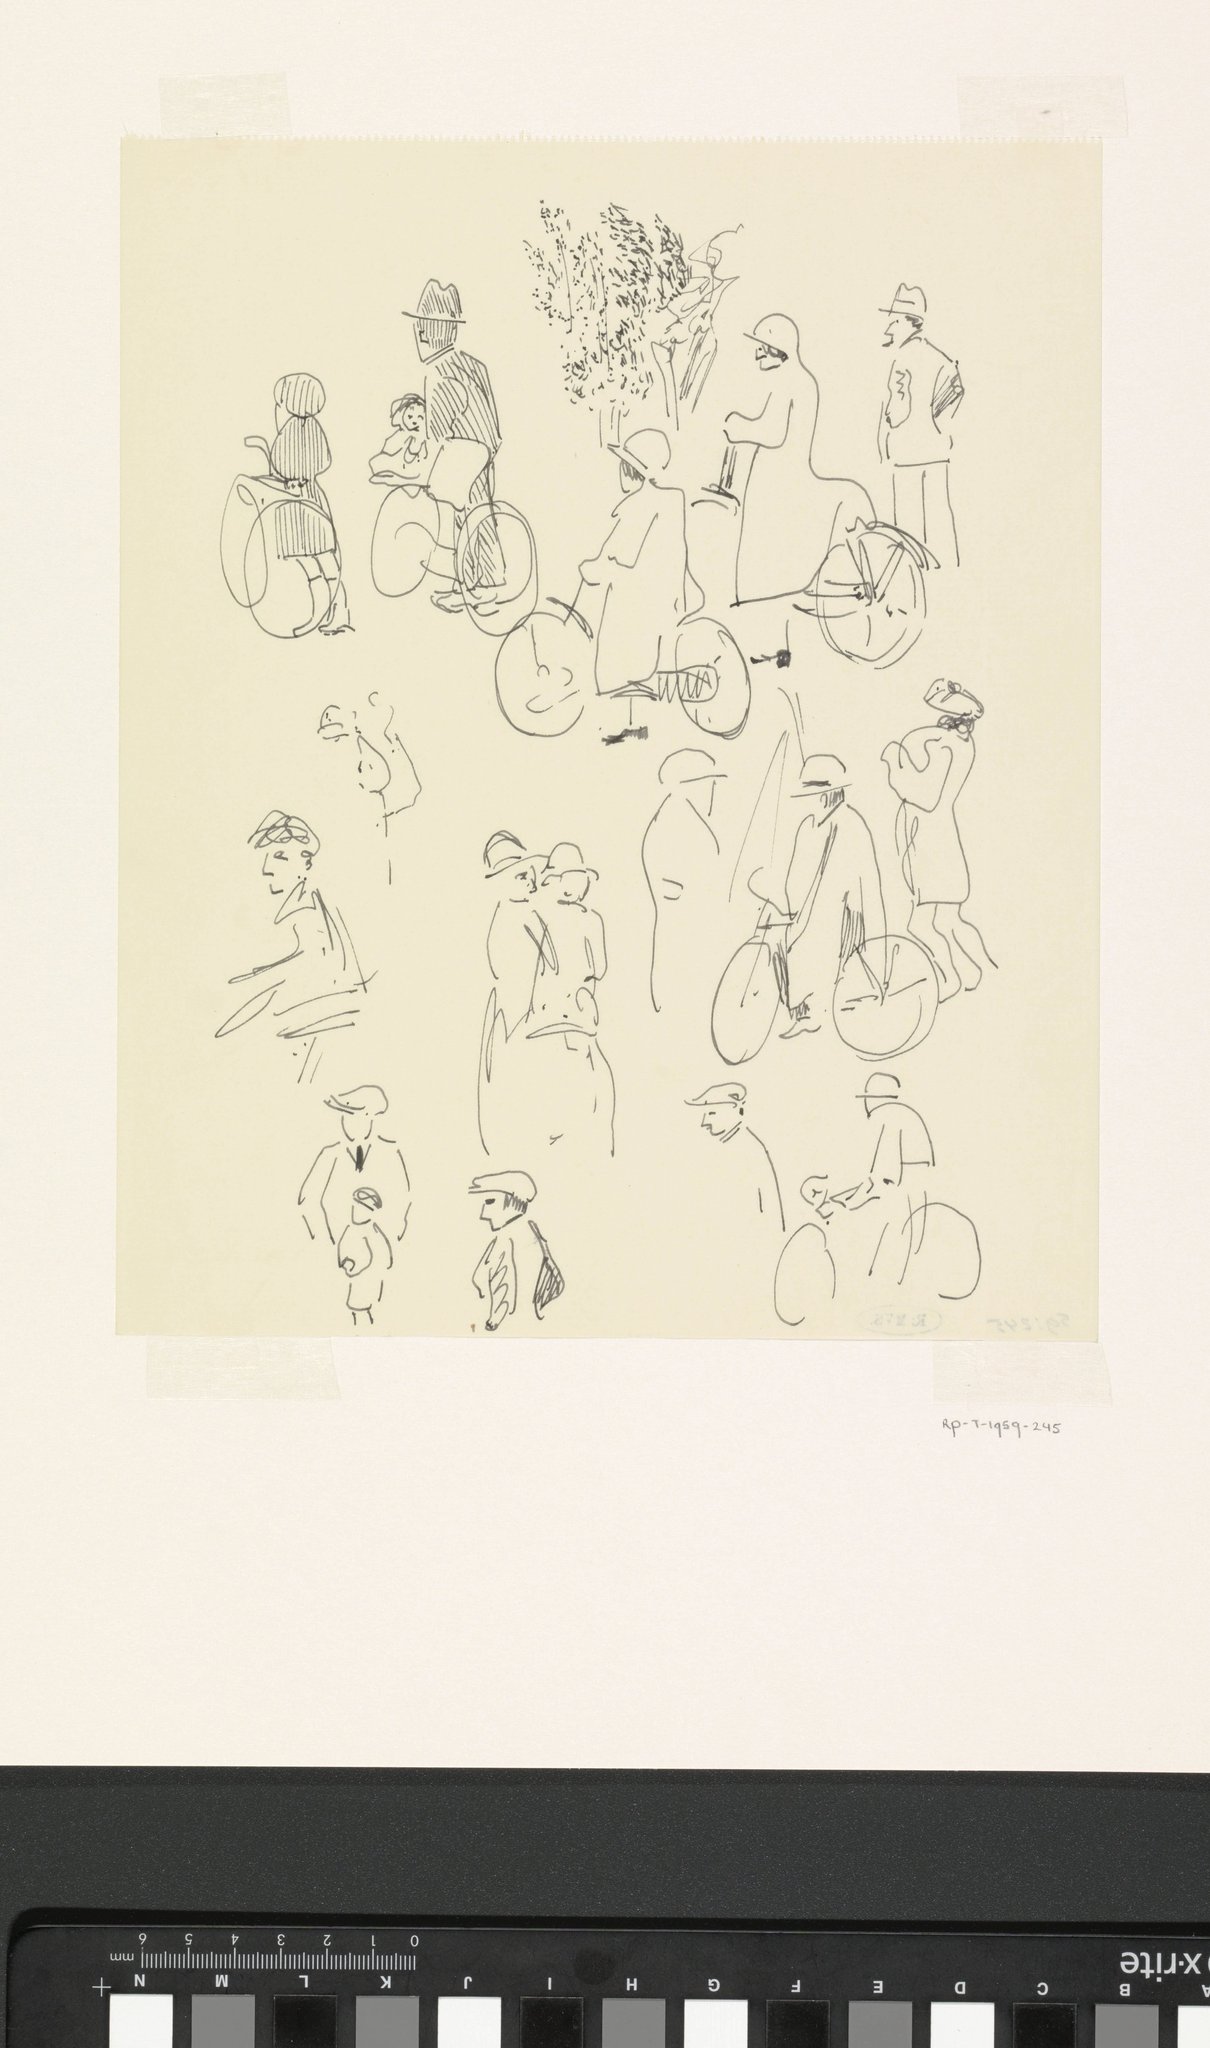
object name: schetsblad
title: Studies van fietsers en wandelaars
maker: carel adolph lion cachet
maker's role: draughtsman, print maker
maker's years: 1864-1945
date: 1874-1945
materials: ink, paper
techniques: pen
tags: bicycle